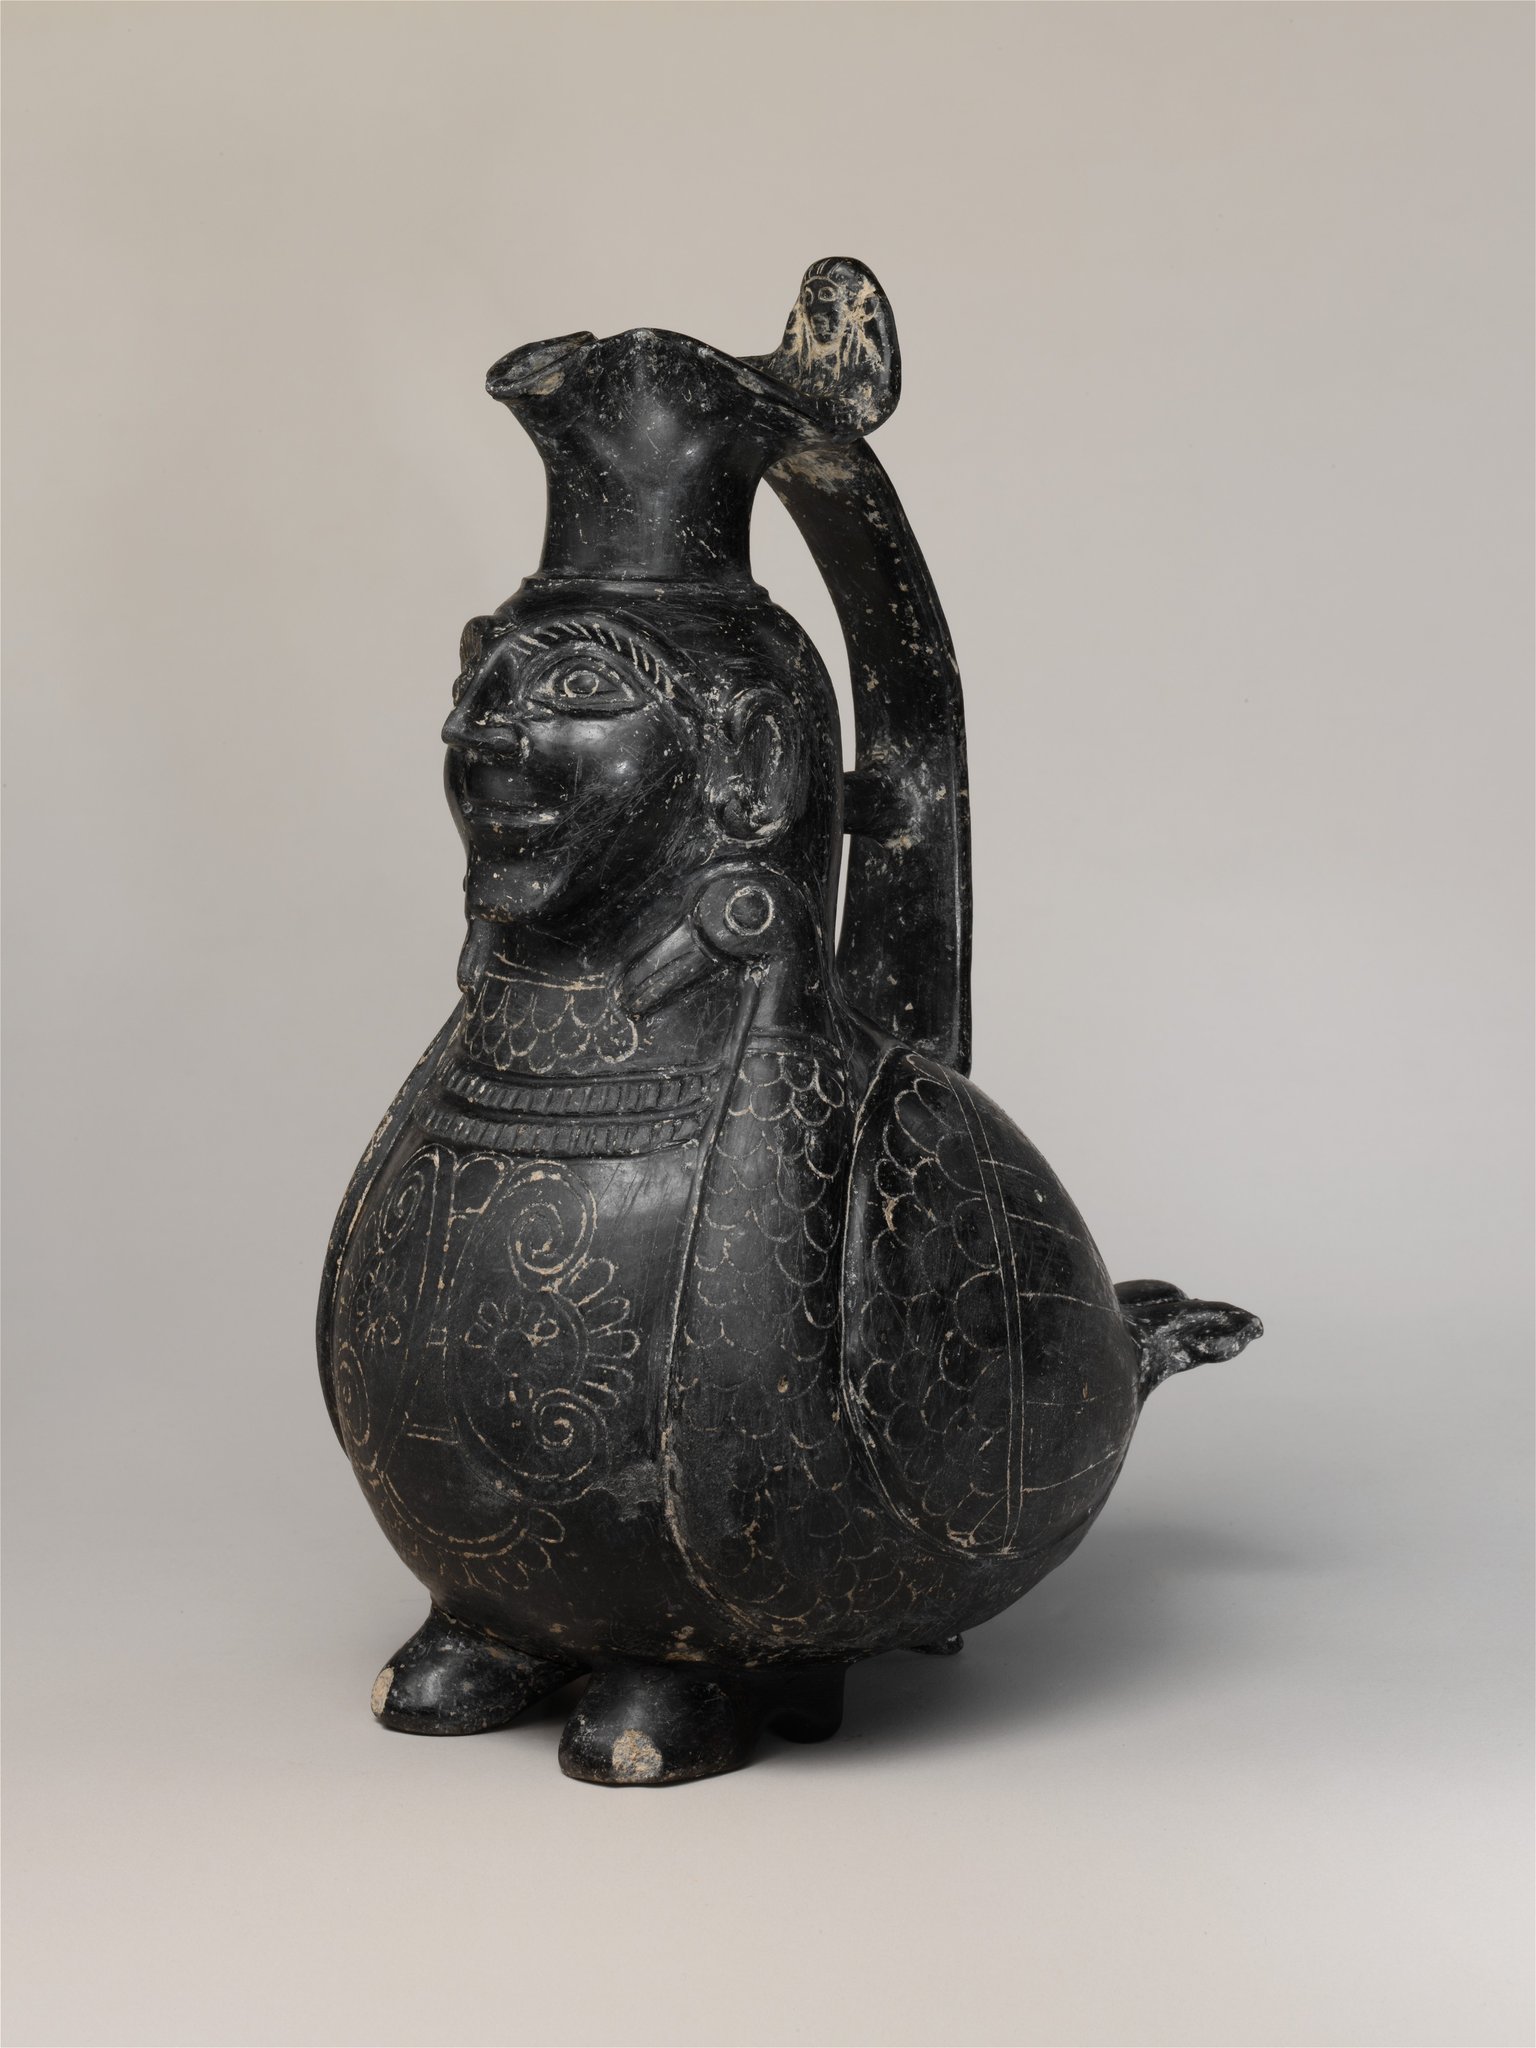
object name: jug in the form of a siren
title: Terracotta jug in the shape of a siren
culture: etruscan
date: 550-500 BCE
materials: terracotta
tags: sirens